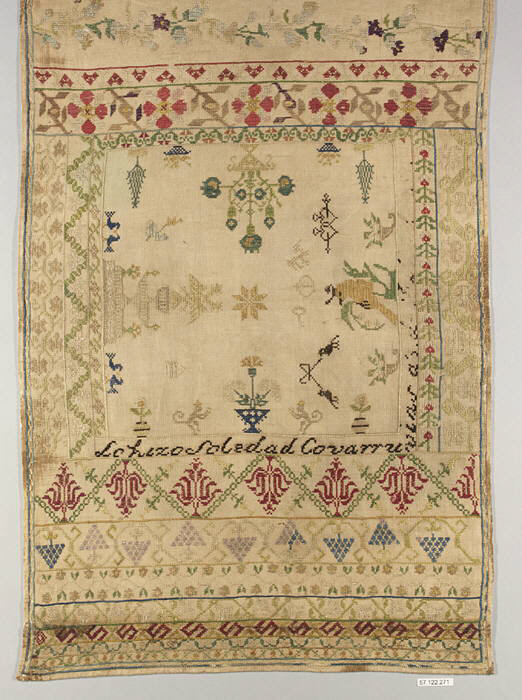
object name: sampler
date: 1801-1900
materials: linen, silk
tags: birds,monkeys,flowers